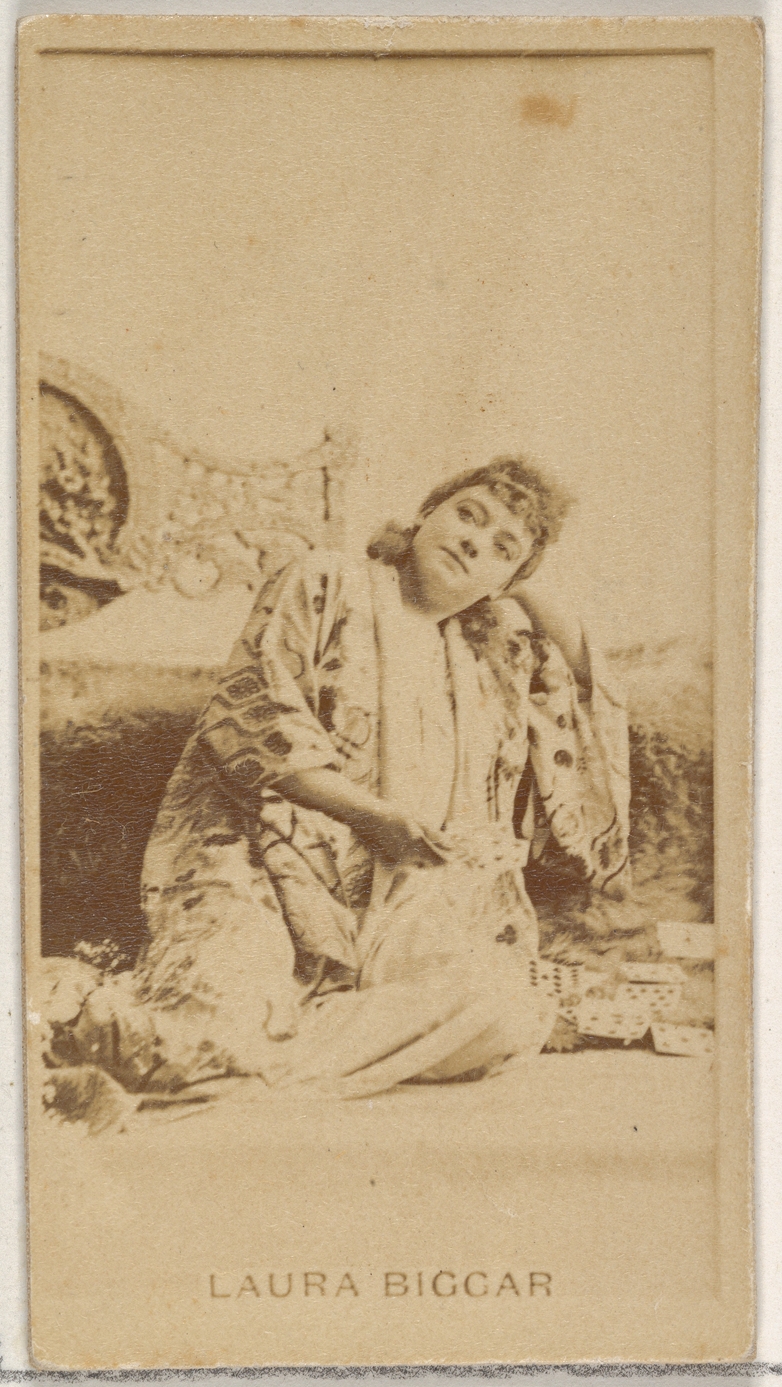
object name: photograph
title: Laura Biggar, from the Actors and Actresses series (N45, Type 8) for Virginia Brights Cigarettes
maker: allen & ginter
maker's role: publisher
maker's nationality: american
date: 1888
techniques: albumen silver print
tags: portraits,women,actresses